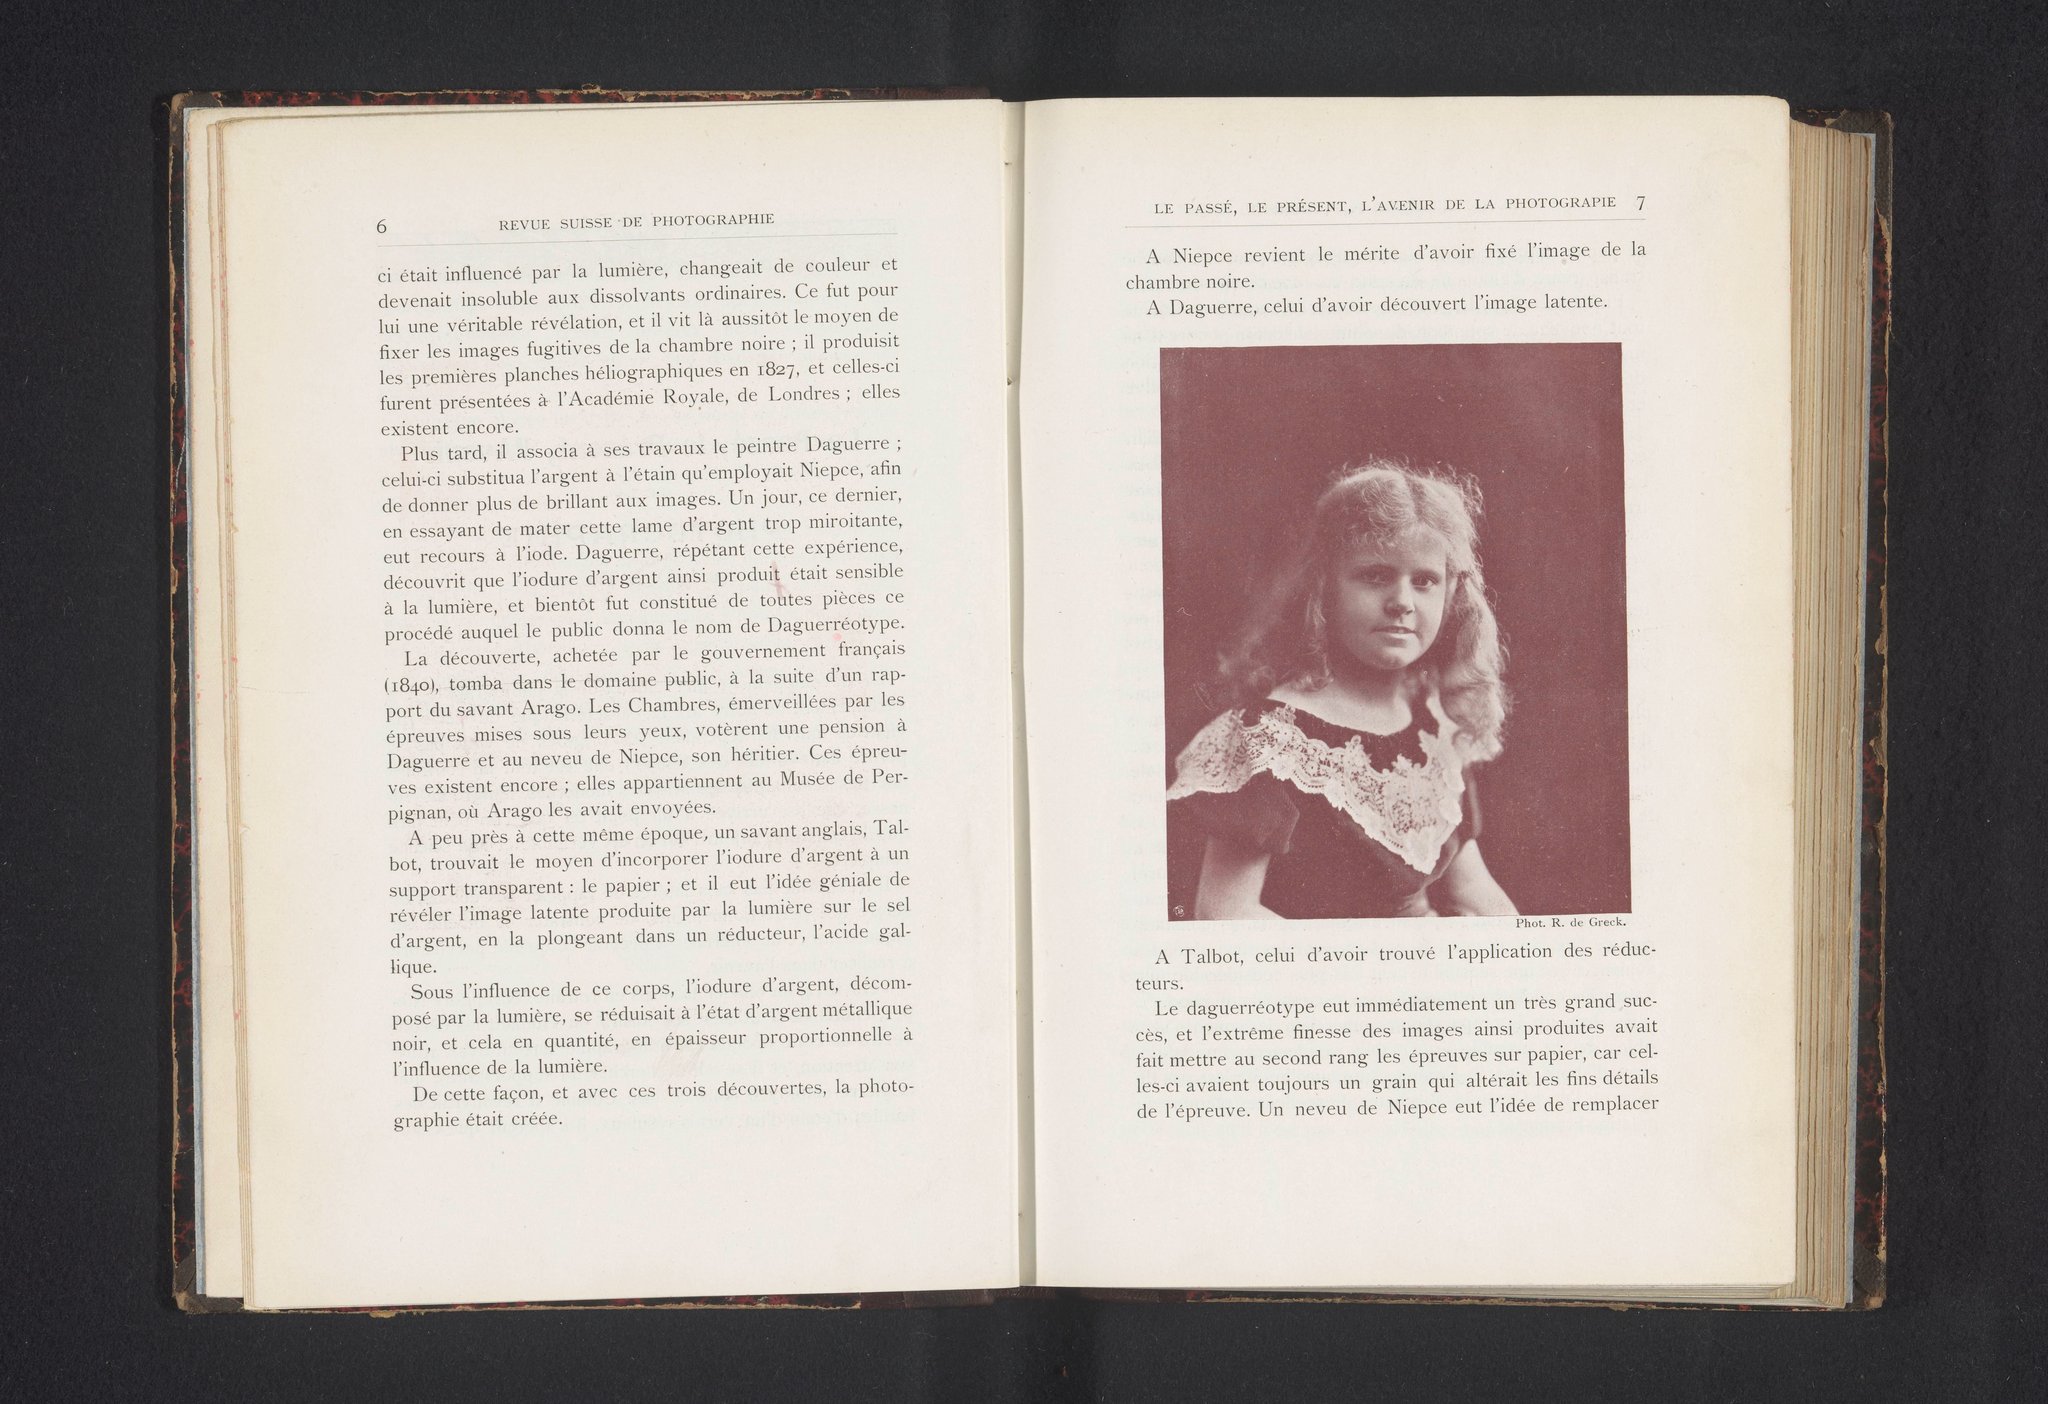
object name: page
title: Portret van een onbekend meisje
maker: robert de greck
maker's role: fotograaf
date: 1897-1902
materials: paper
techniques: autotype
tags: historical persons - bb - woman, girl (child between toddler and youth)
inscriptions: monogram: ‘C. Cie’